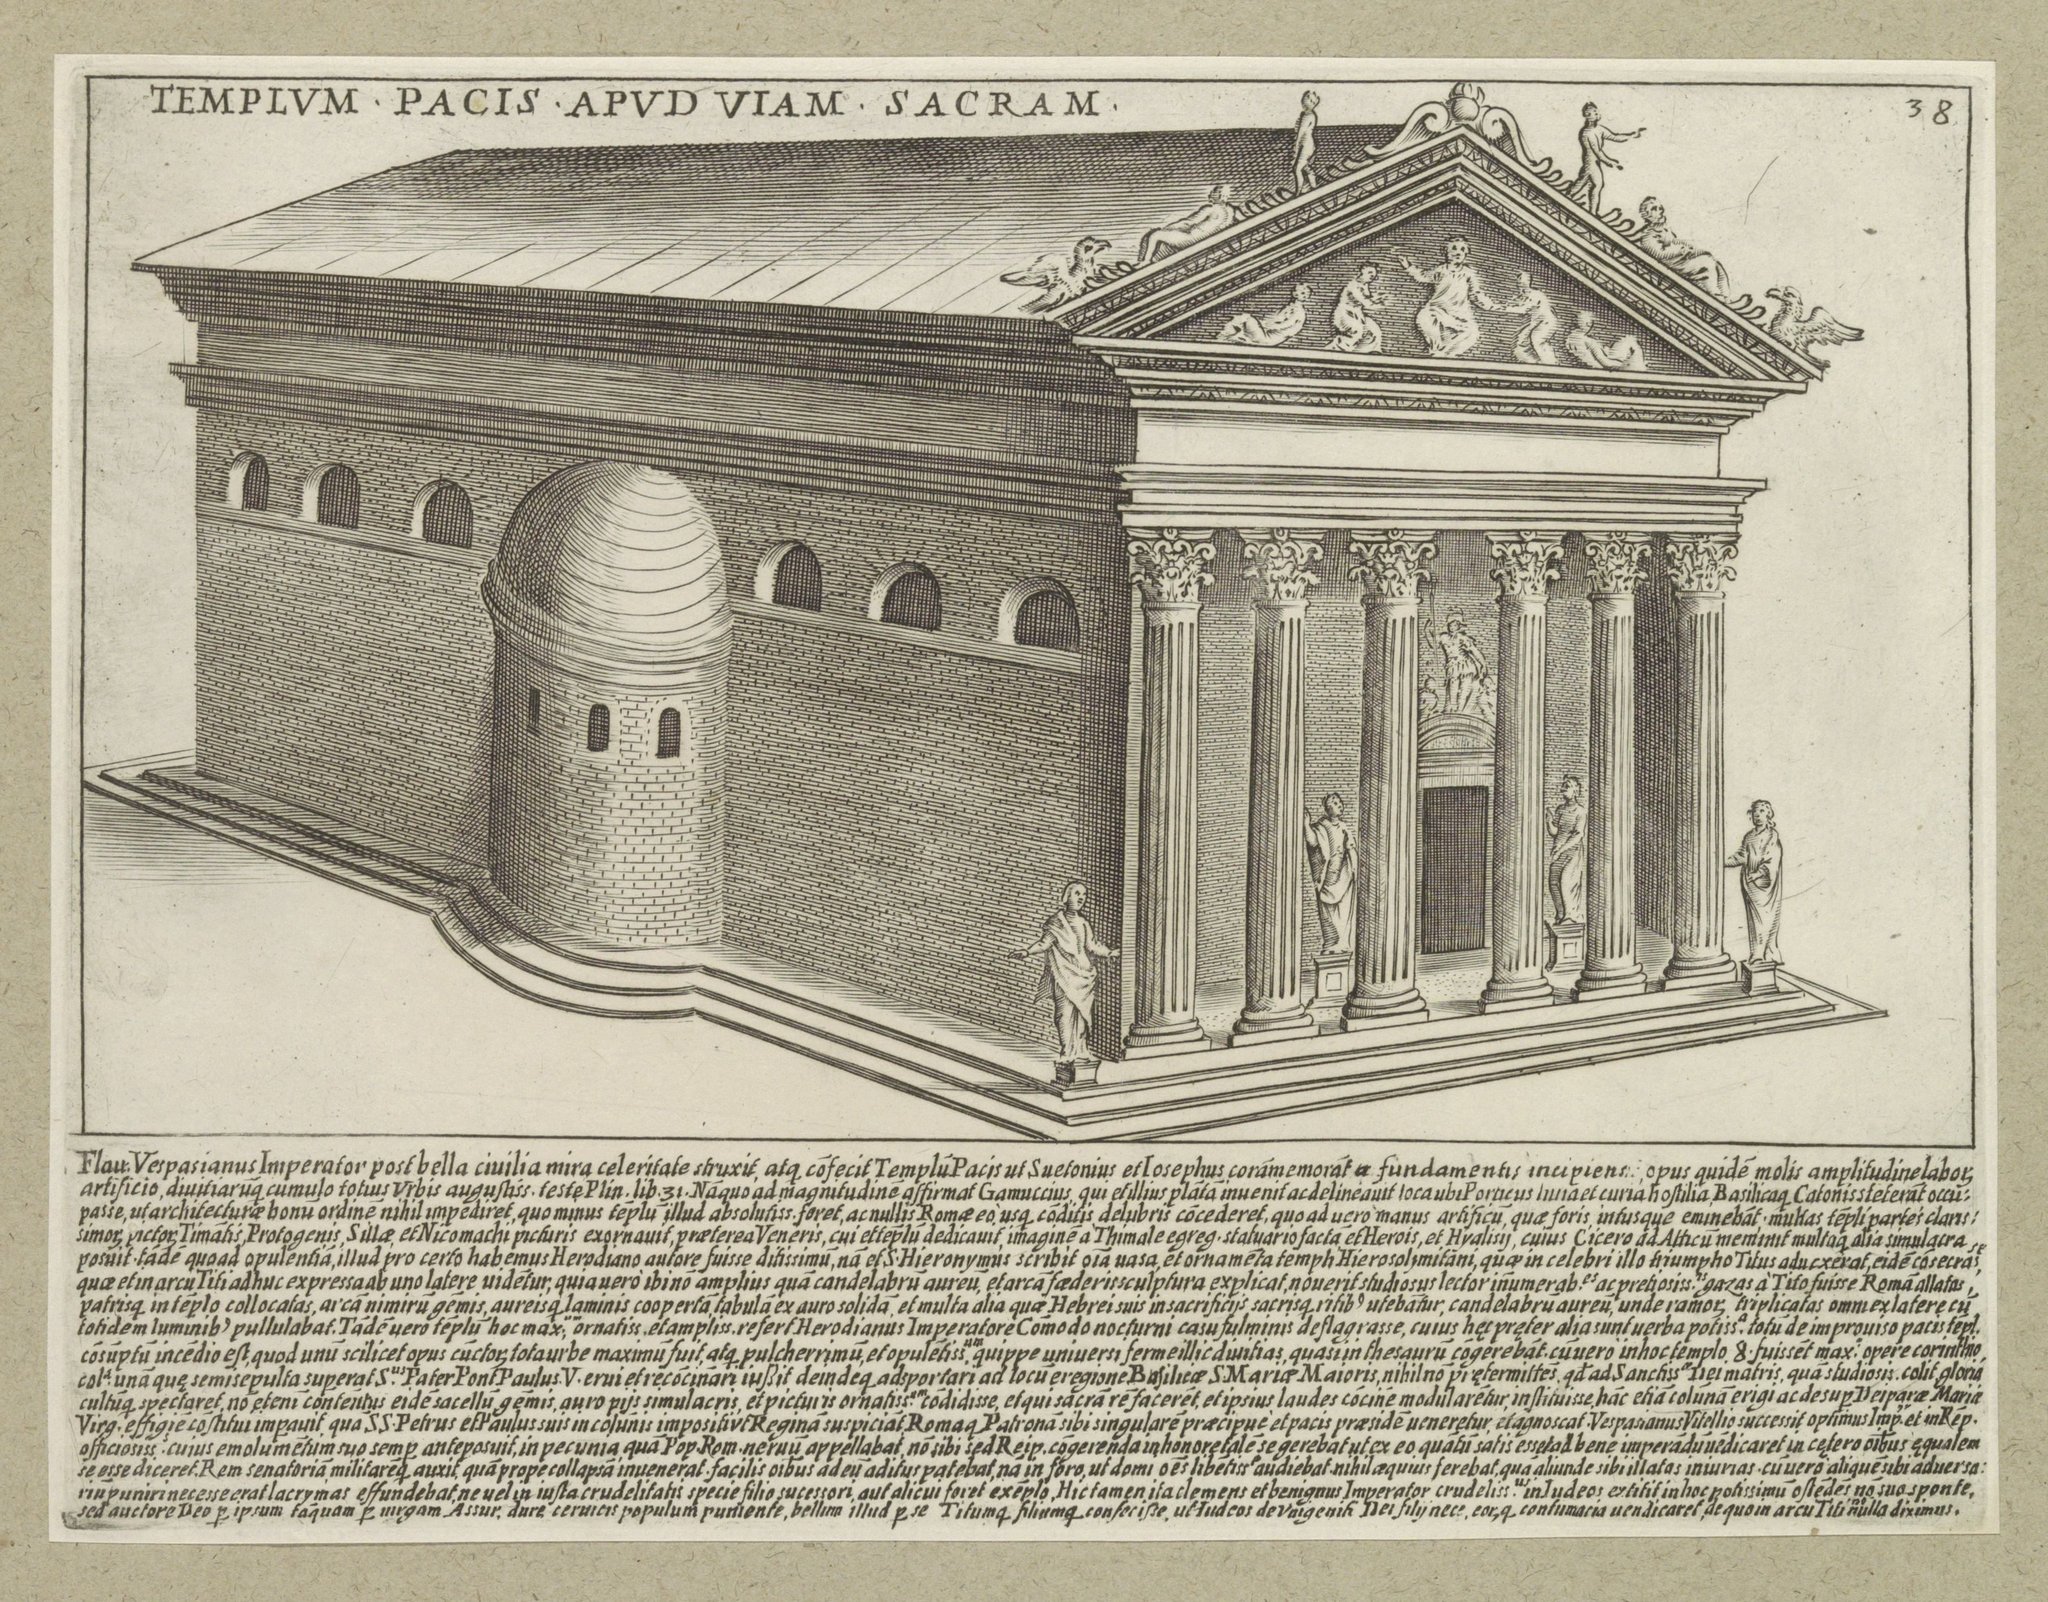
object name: album leaf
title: Antiquae Urbis Splendor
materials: paper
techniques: etching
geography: rome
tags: temple, shrine ~ roman religion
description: Deze prent maakt deel uit van een set van 158 prenten (+ titelprenten), die verscheen in vier delen. In 1612 verschenen delen één en twee. In 1615 verscheen het derde deel en in 1628 verscheen deel vier. In 1637 publiceerde Vitale Mascardi de eerste heruitgave van de gehele set met nummering.